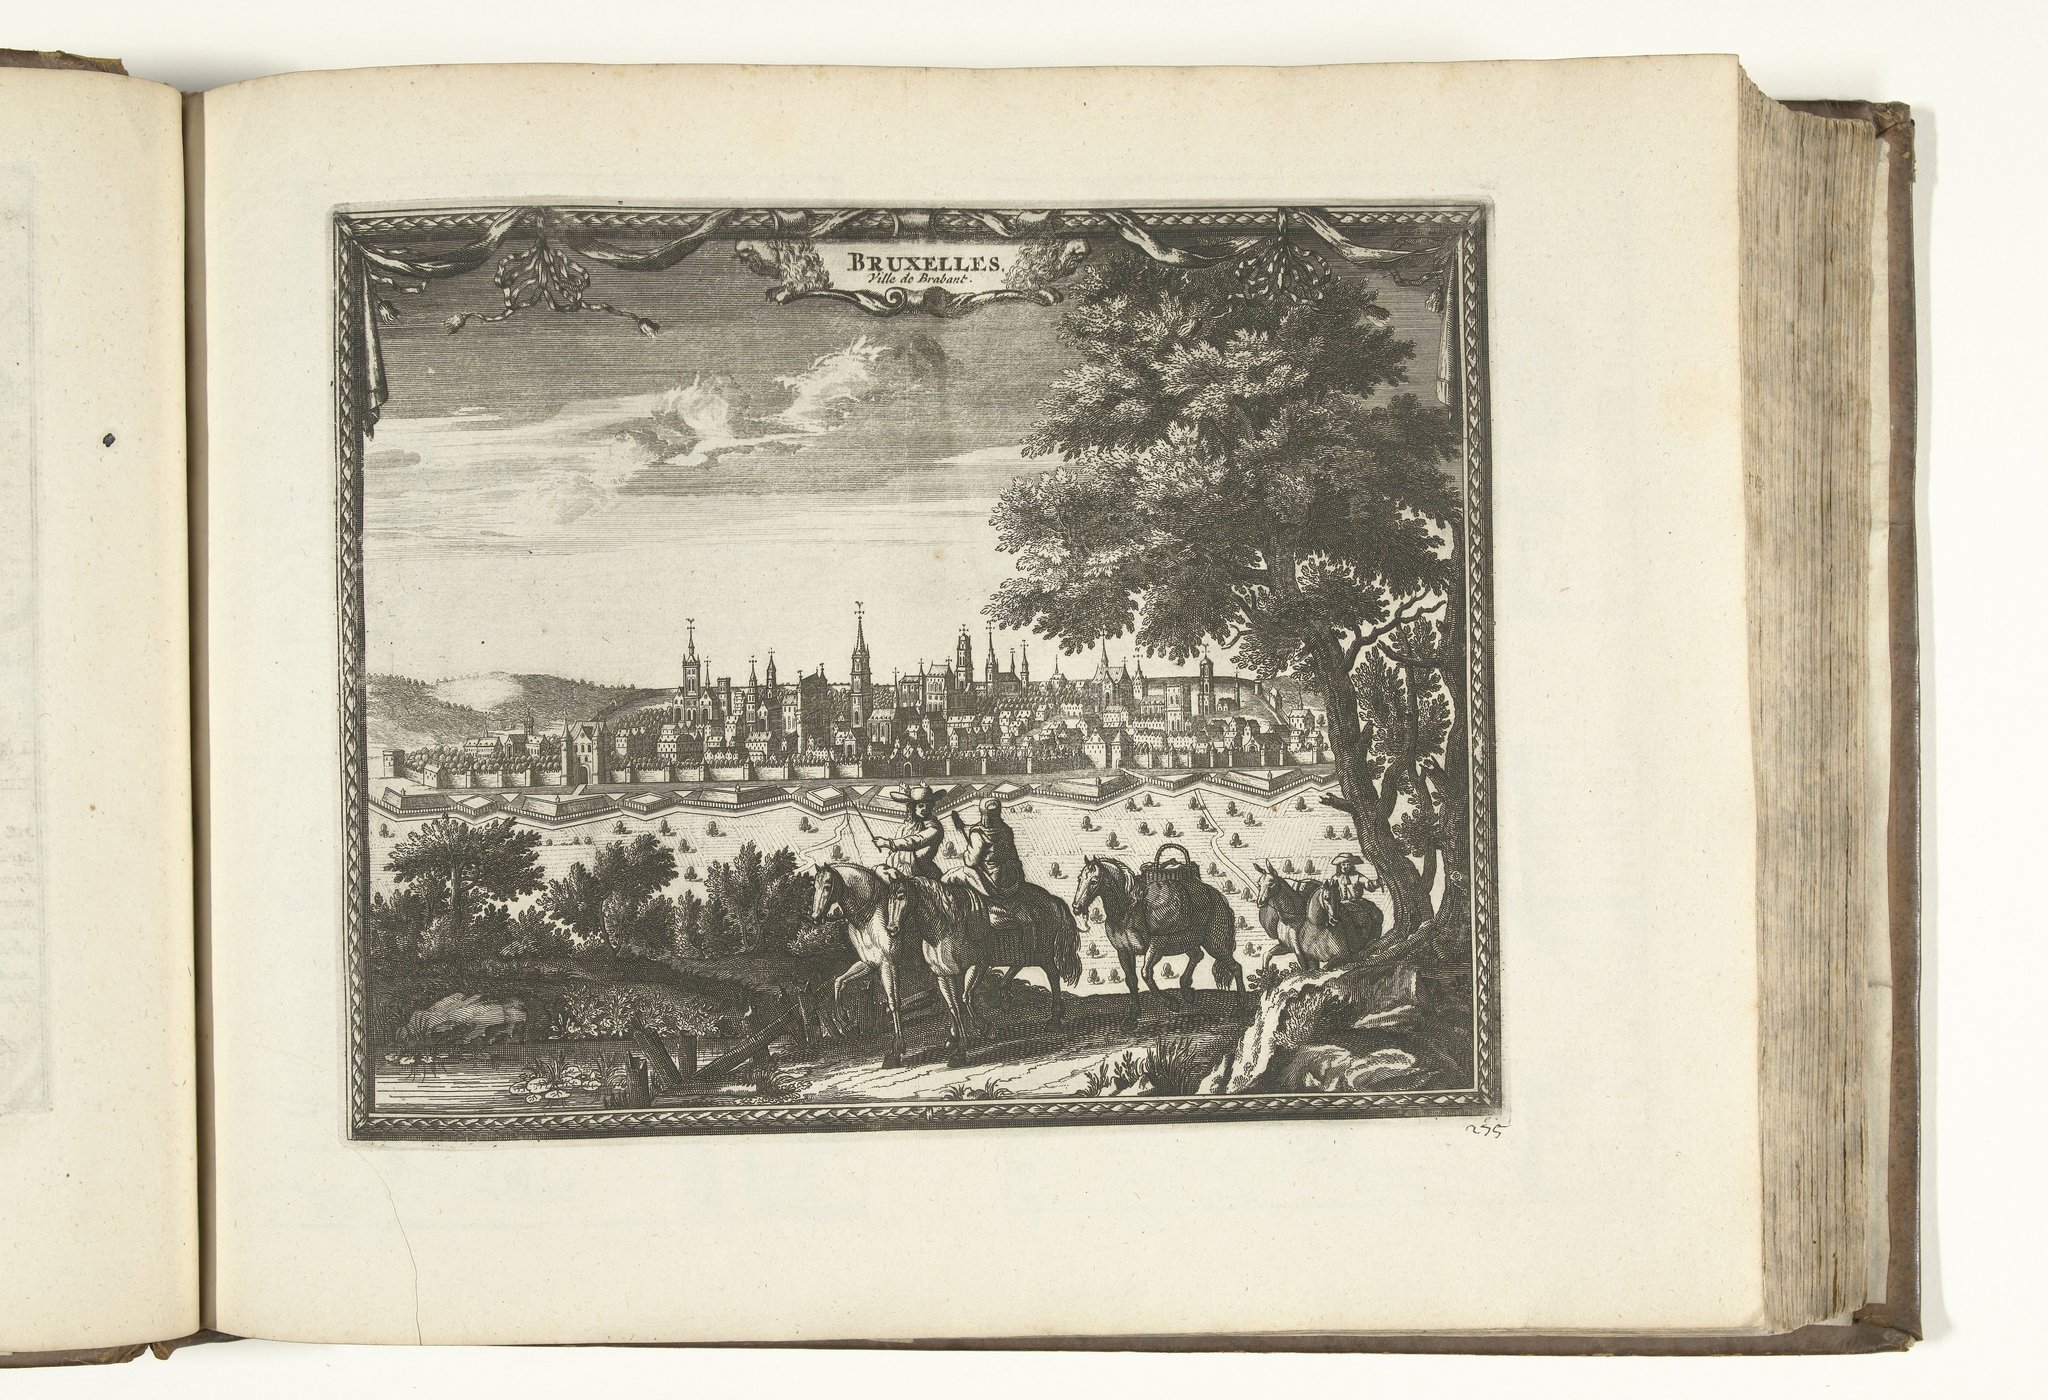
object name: print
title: Les Forces de l'Europe, Asie, Afrique et Amerique (...) Comme aussi les Cartes des Côtes de France et d'Espagne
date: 1726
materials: paper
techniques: etching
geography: leiden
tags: brussels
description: Gezicht op Brussel, op de voorgrond een groep reizigers te paard. Plaat nr. 275 in deel XII van het prentwerk: Les Forces de l'Europe, Asie, Afrique et Amerique ... Comme aussi les Cartes des Côtes de France et d'Espagne uit 1726, dit tweede deel met 271 met de hand genummerde platen van vermaarde sterke steden en vestingen in het kader van de Spaanse Successieoorlog 1701-1713. Voor het merendeel zijn deze platen gekopieerd naar de anonieme Franse platen van vermaarde sterke steden en vestingen: in Les forces de l'Europe en in: Le theatre de la guerre, dans les Pays-Bas, beide oorspronkelijk uitgegeven door Nicolas de Fer te Parijs (1693-1697) in het kader van de Negenjarige Oorlog. Titel in het Frans.